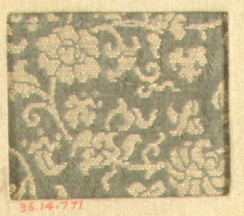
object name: piece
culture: japanese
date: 1701-1900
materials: silk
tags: flowers